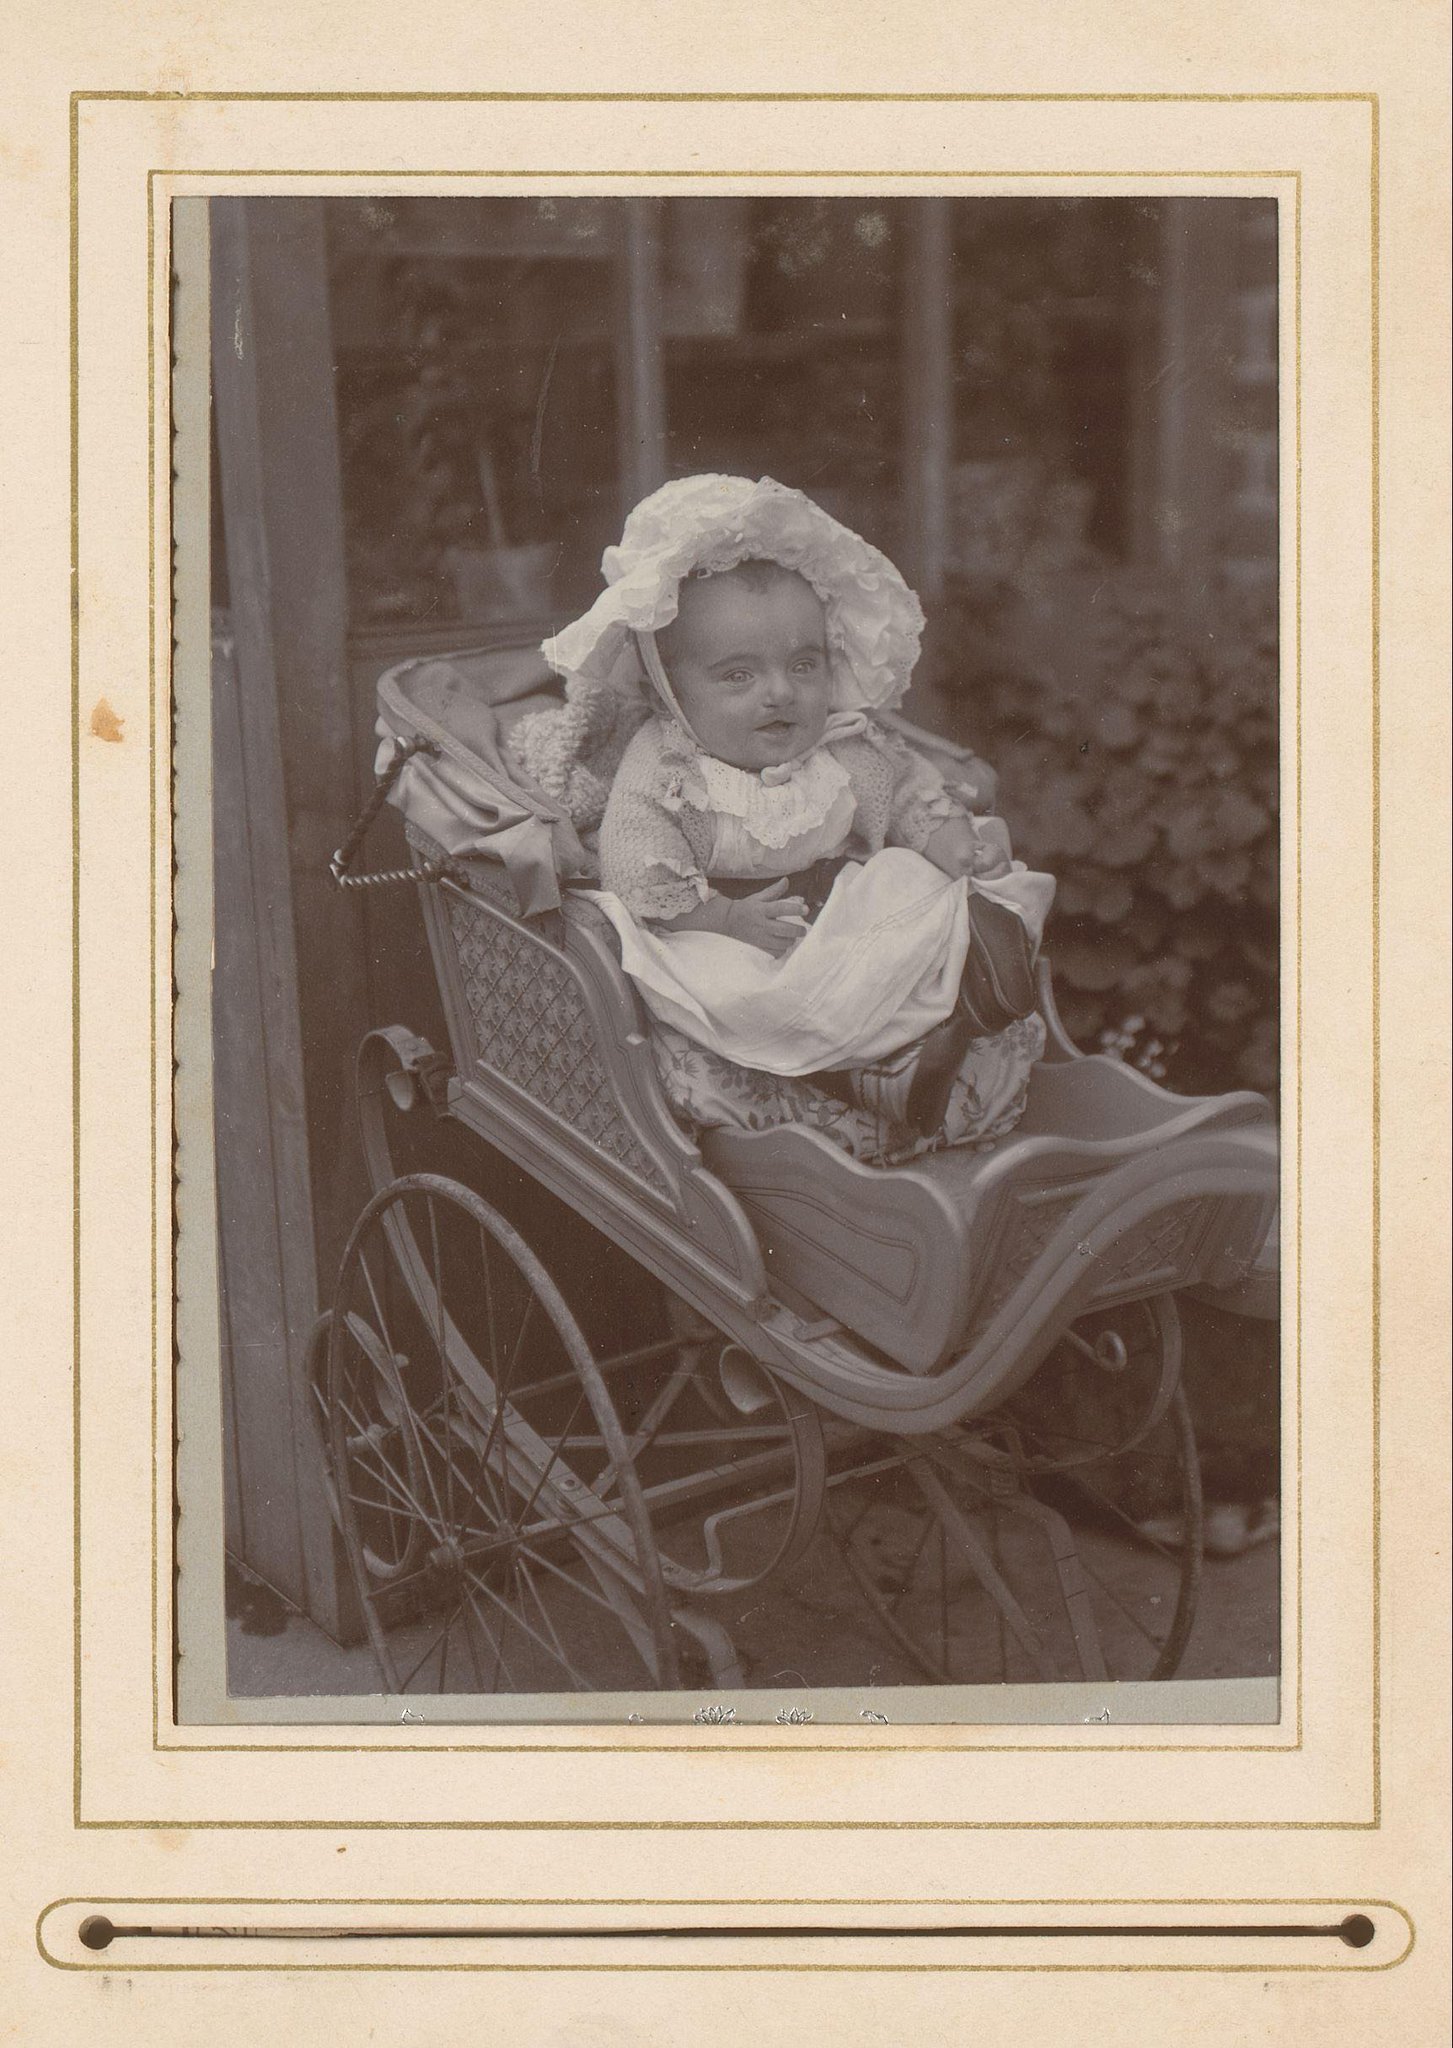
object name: photograph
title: Baby in een kinderwagen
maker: Anonymous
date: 1880-1910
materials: cardboard, photographic support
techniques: albumen print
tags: baby-carriage, pram, perambulator, historical persons, infant, baby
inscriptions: inscription: ‘Souvenir’